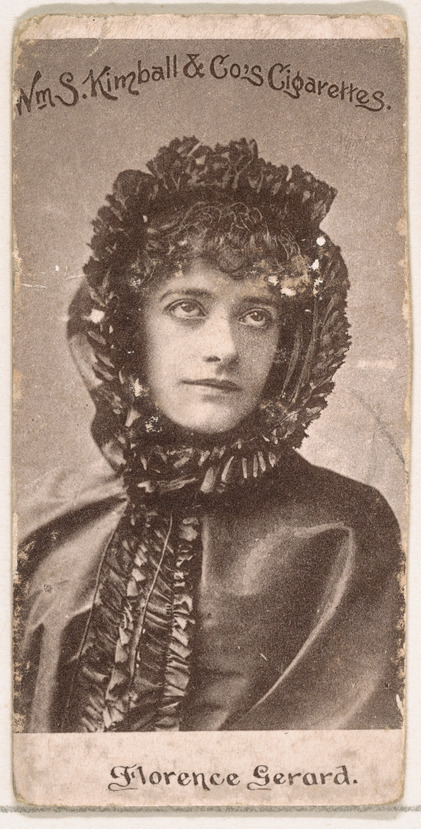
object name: print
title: Florence Gerard, from the Actresses series (N190) issued by Wm. S. Kimball & Co.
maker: william s. kimball & company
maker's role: publisher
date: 1889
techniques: lithography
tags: portraits,women,actresses